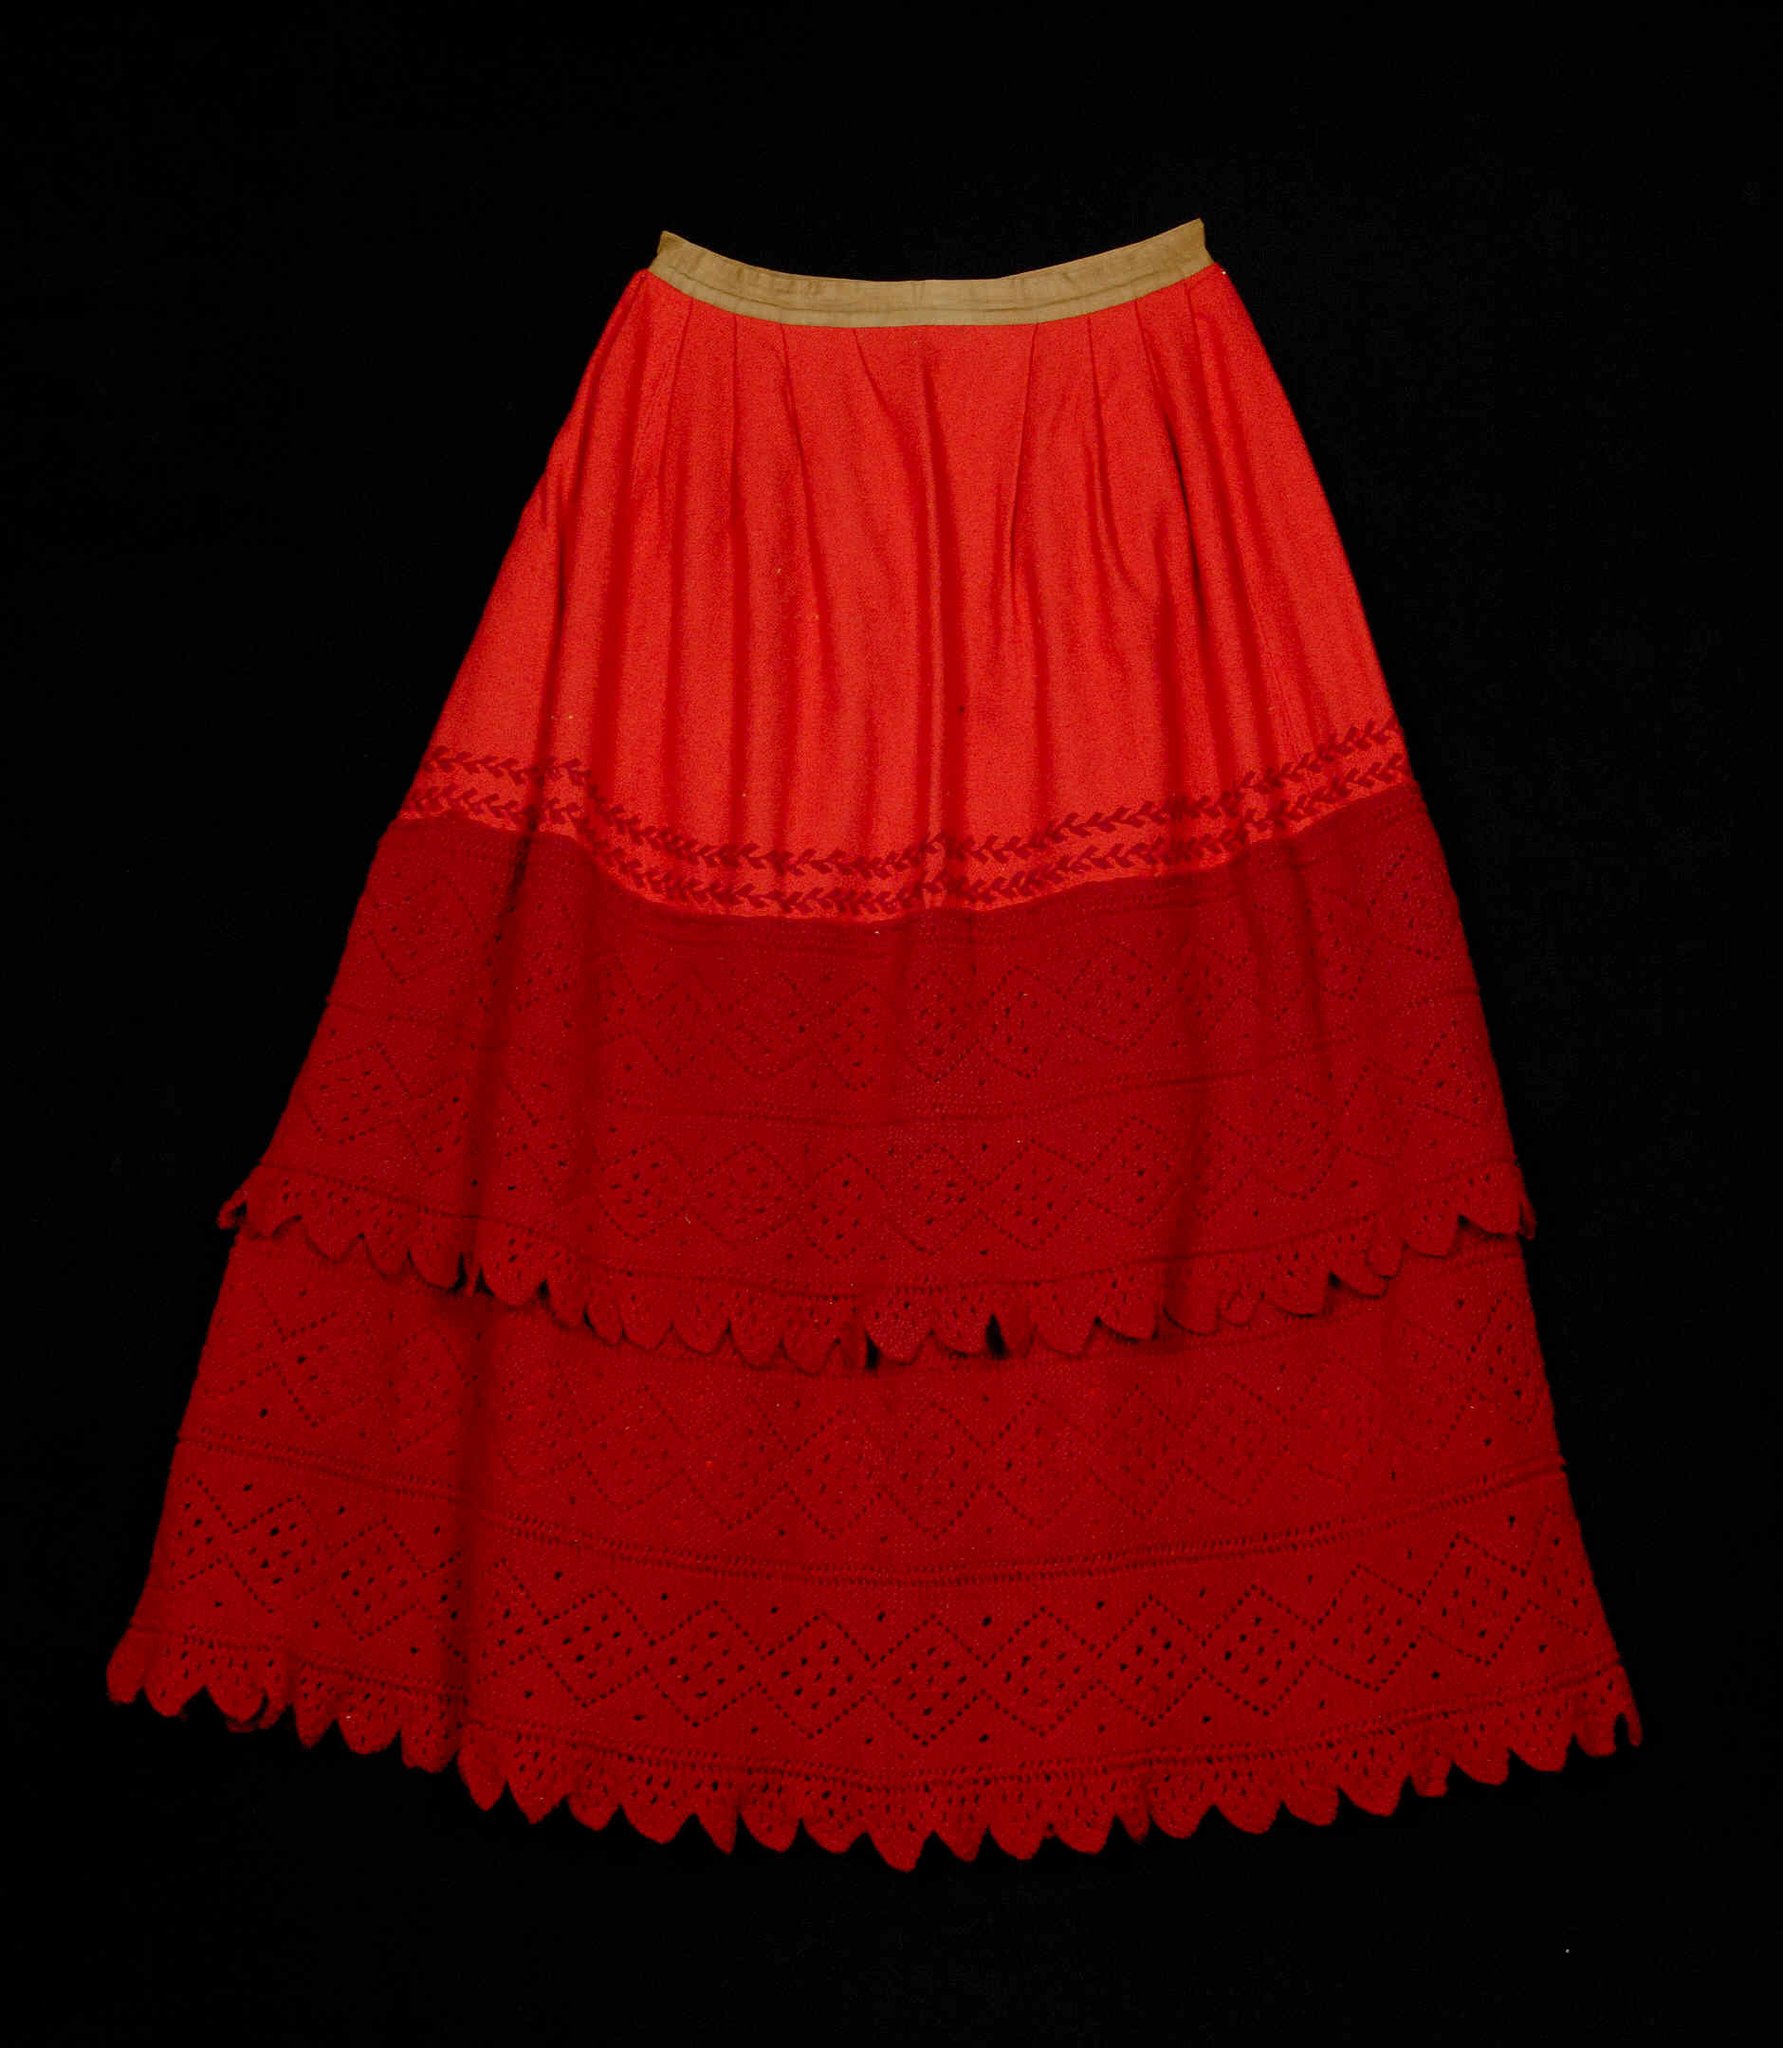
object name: underwear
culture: american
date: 1865-1870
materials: cotton, wool